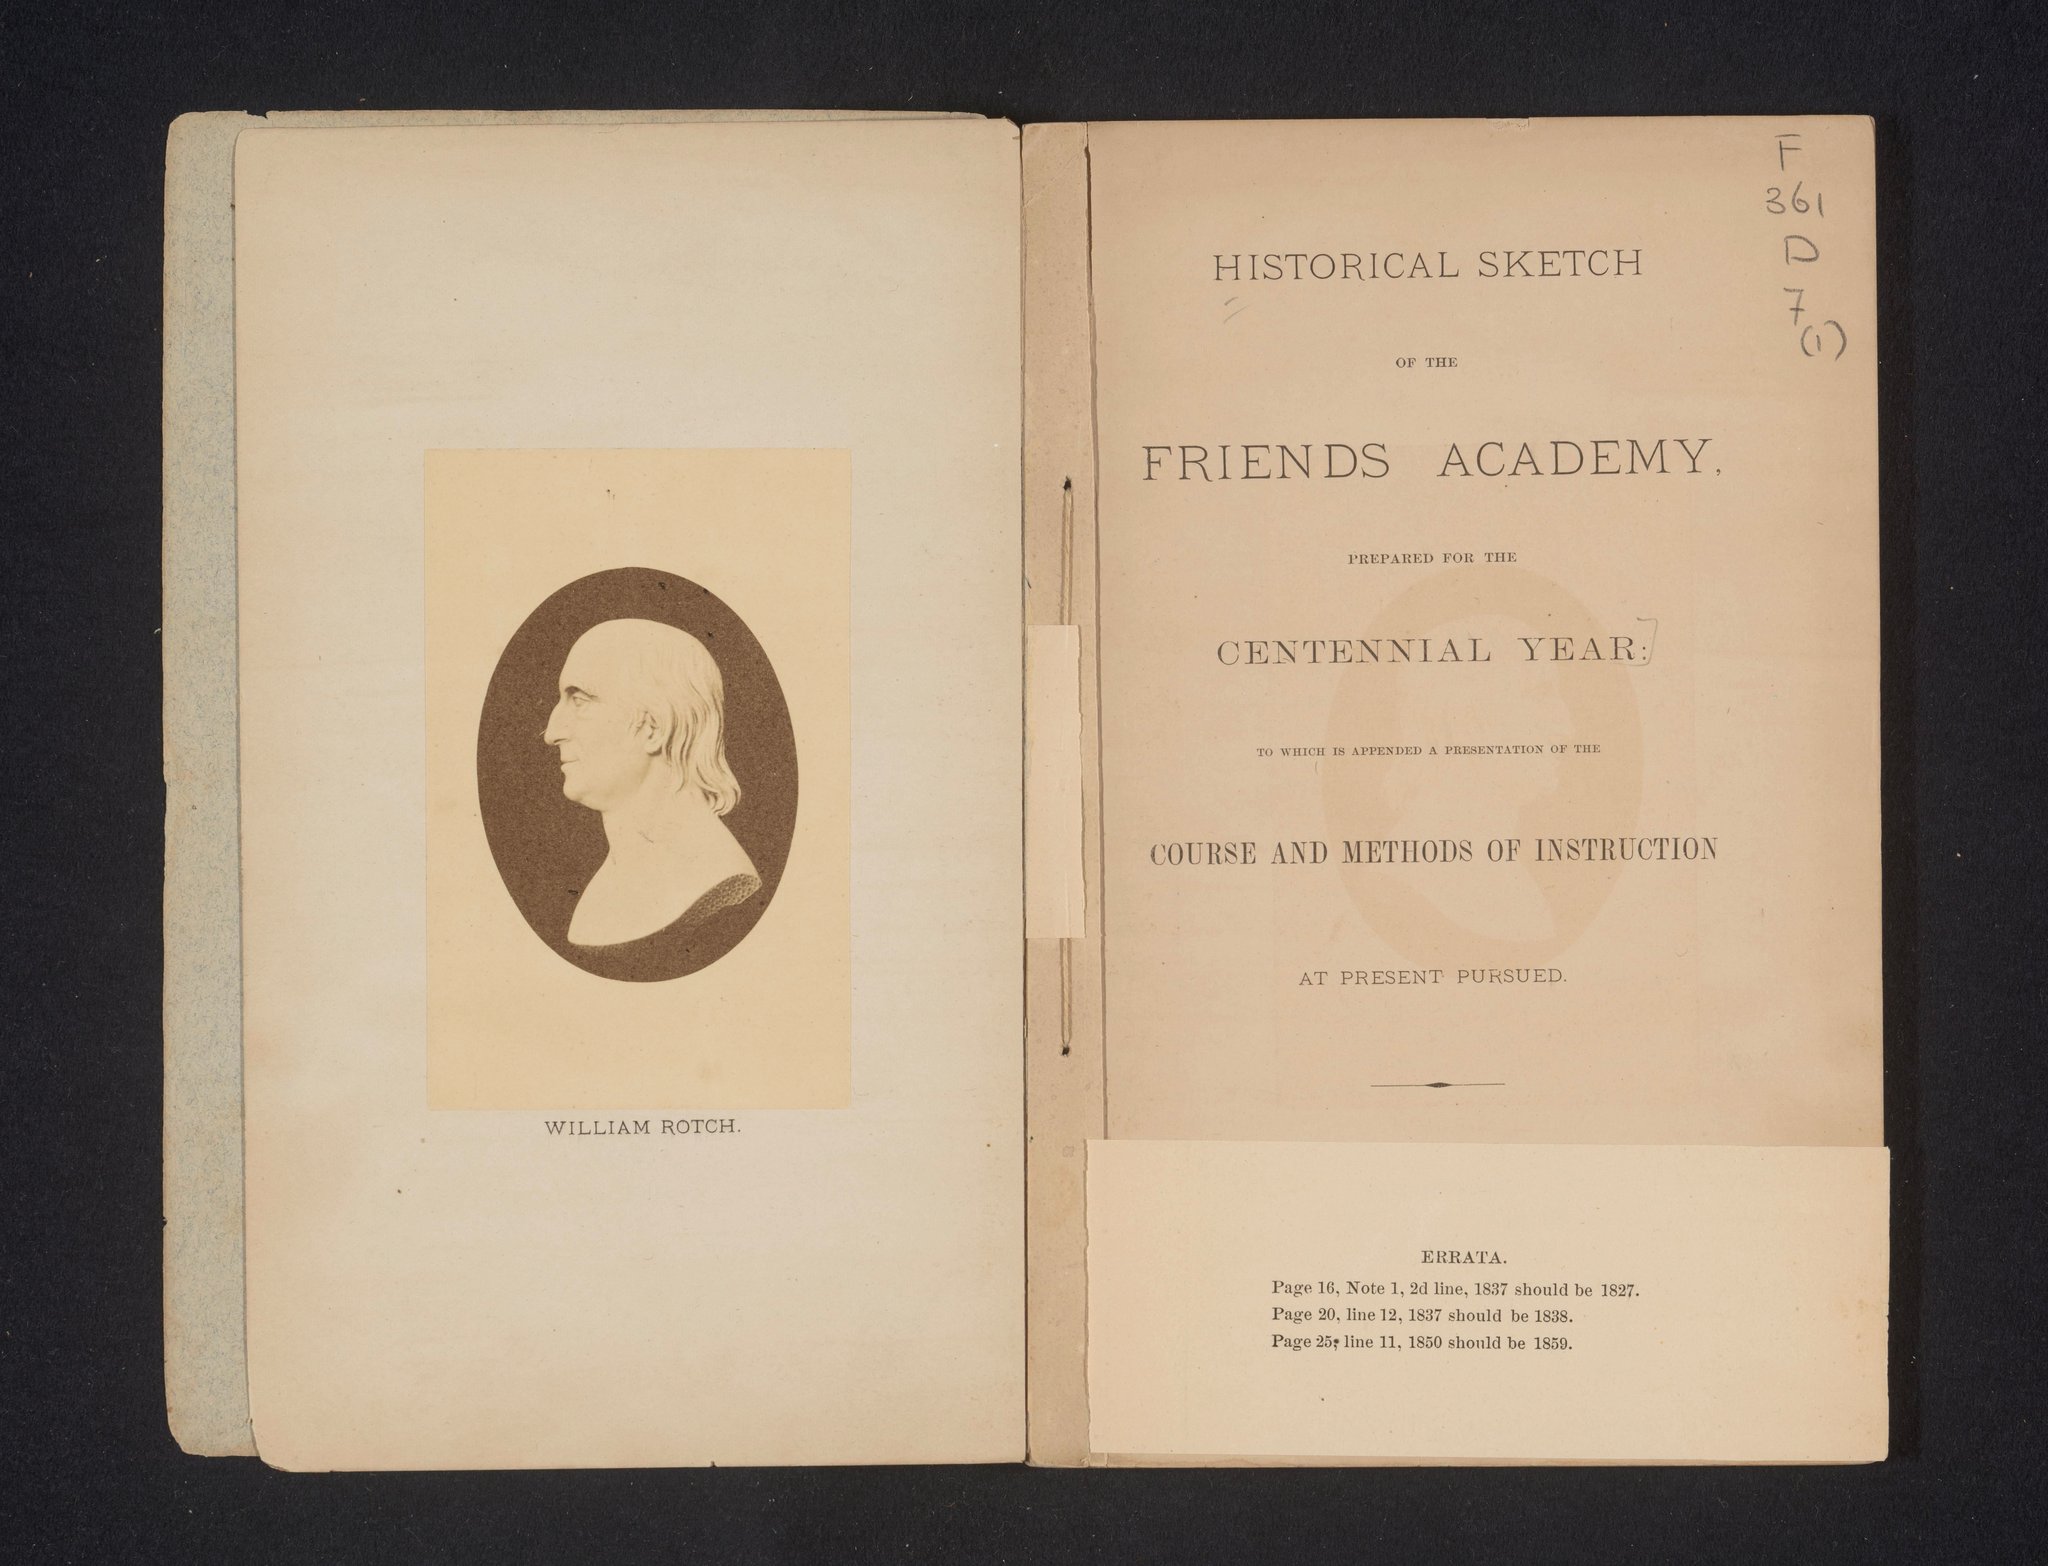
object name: photograph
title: Buste van William J. Rotch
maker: Anonymous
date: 1871-1876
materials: photographic support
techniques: albumen print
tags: historical persons, piece of sculpture, reproduction of a piece of sculpture